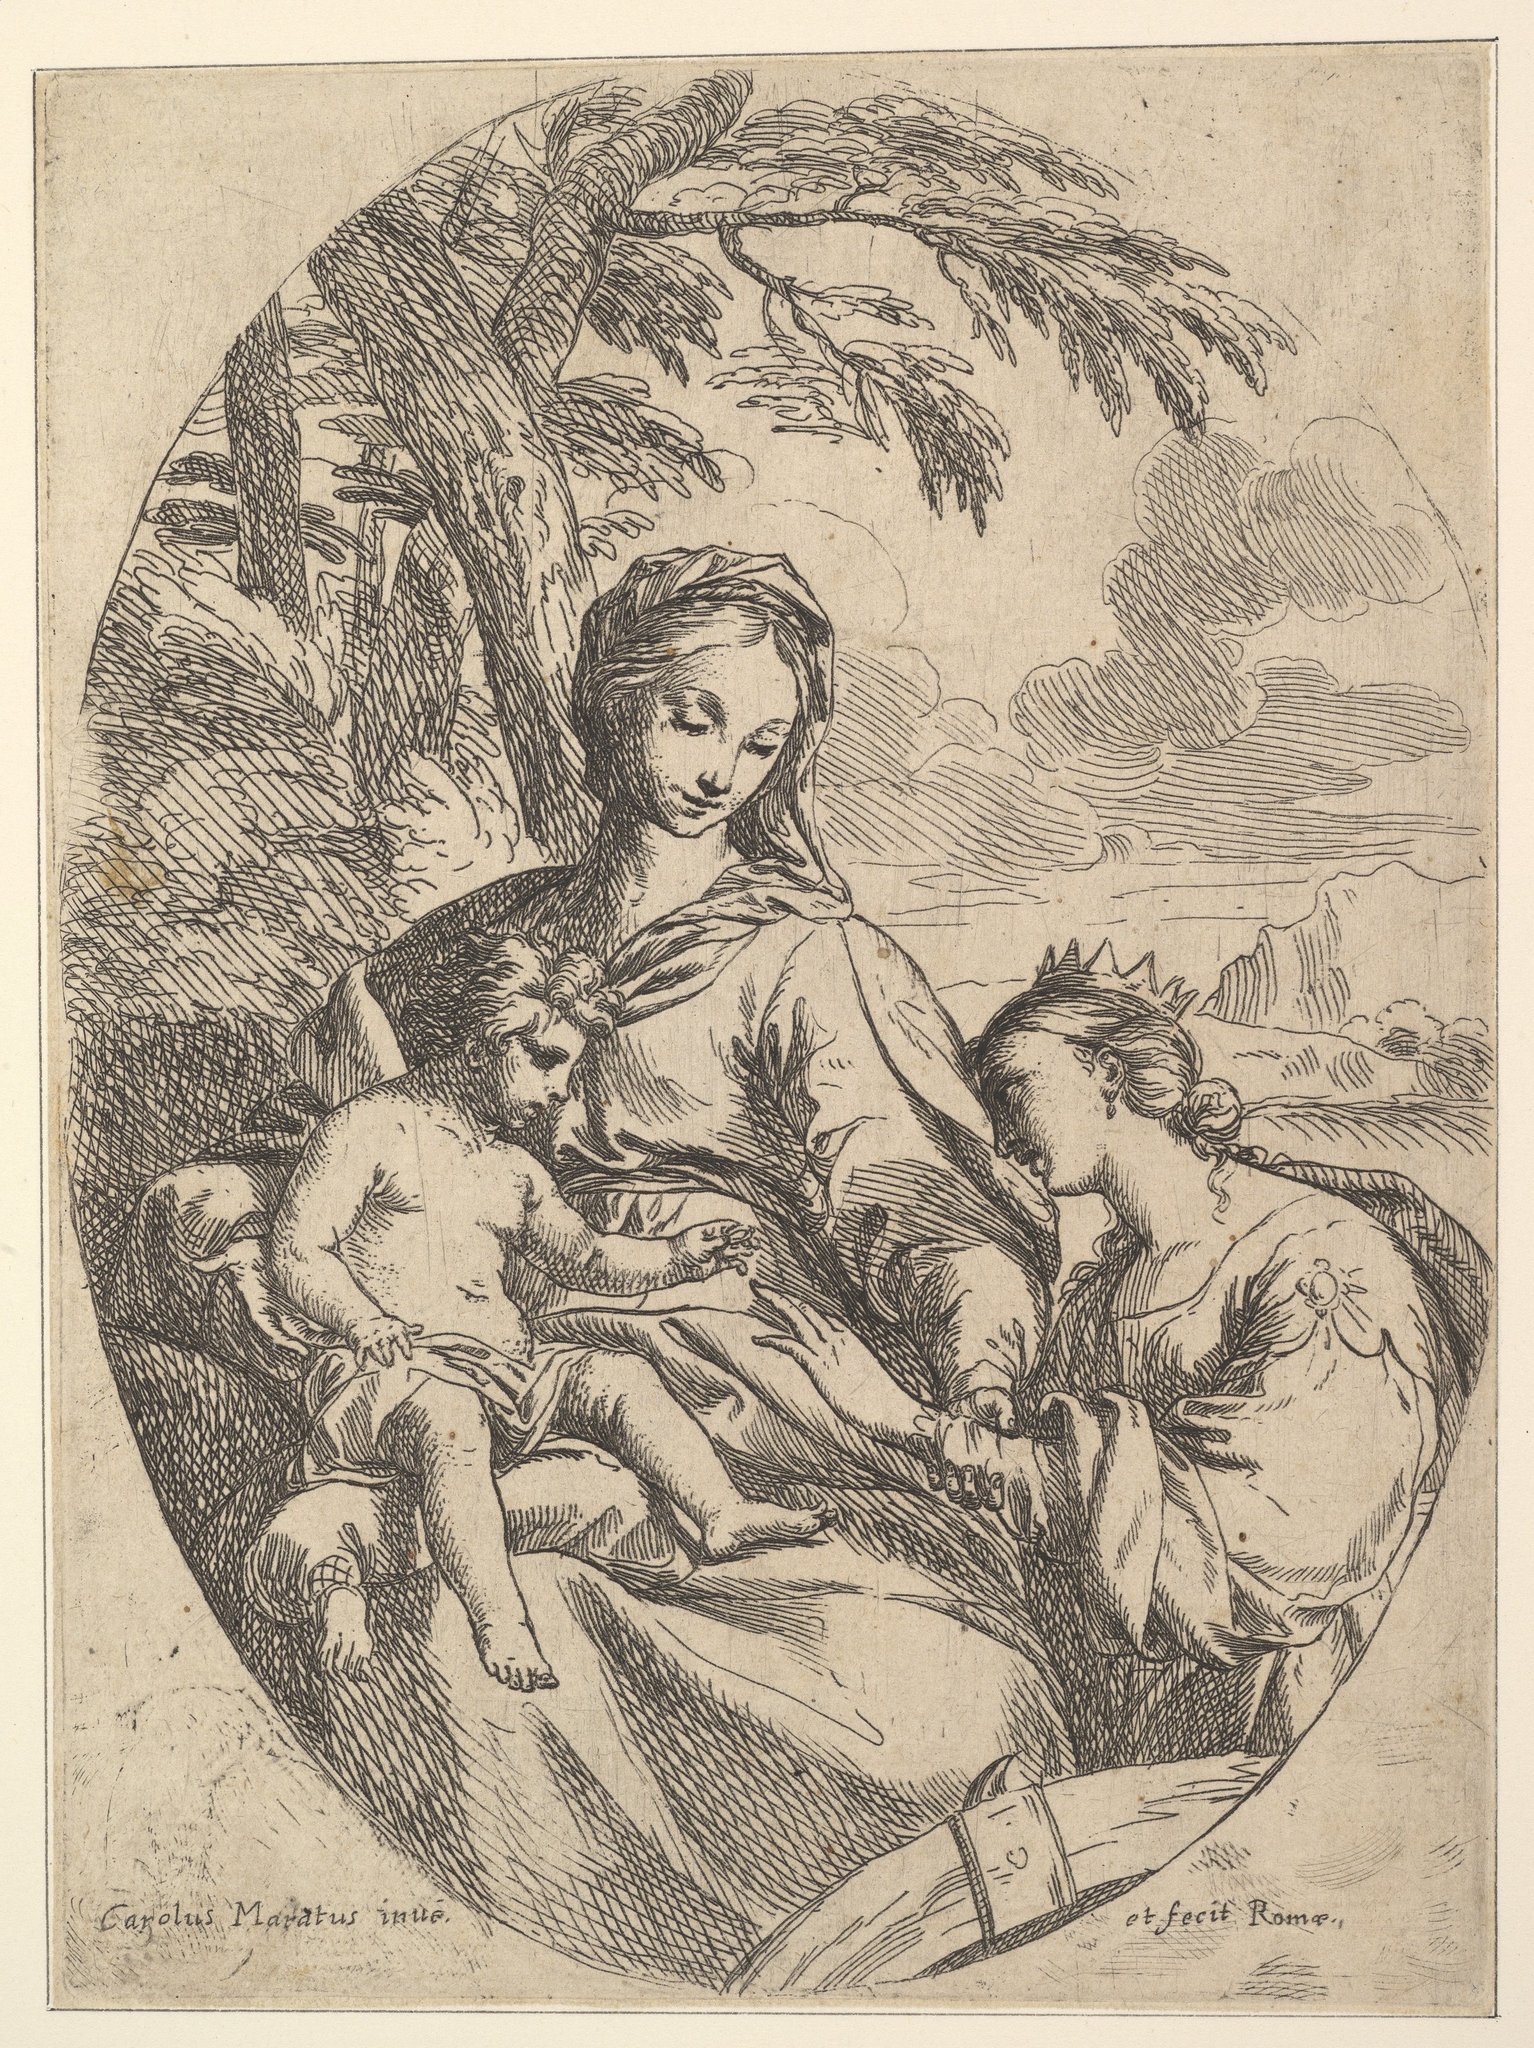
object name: print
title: The Marriage of St. Catherine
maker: carlo maratti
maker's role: artist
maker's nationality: italian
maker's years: 1625-1713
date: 1625-1713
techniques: etching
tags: madonna and child,saint catherine